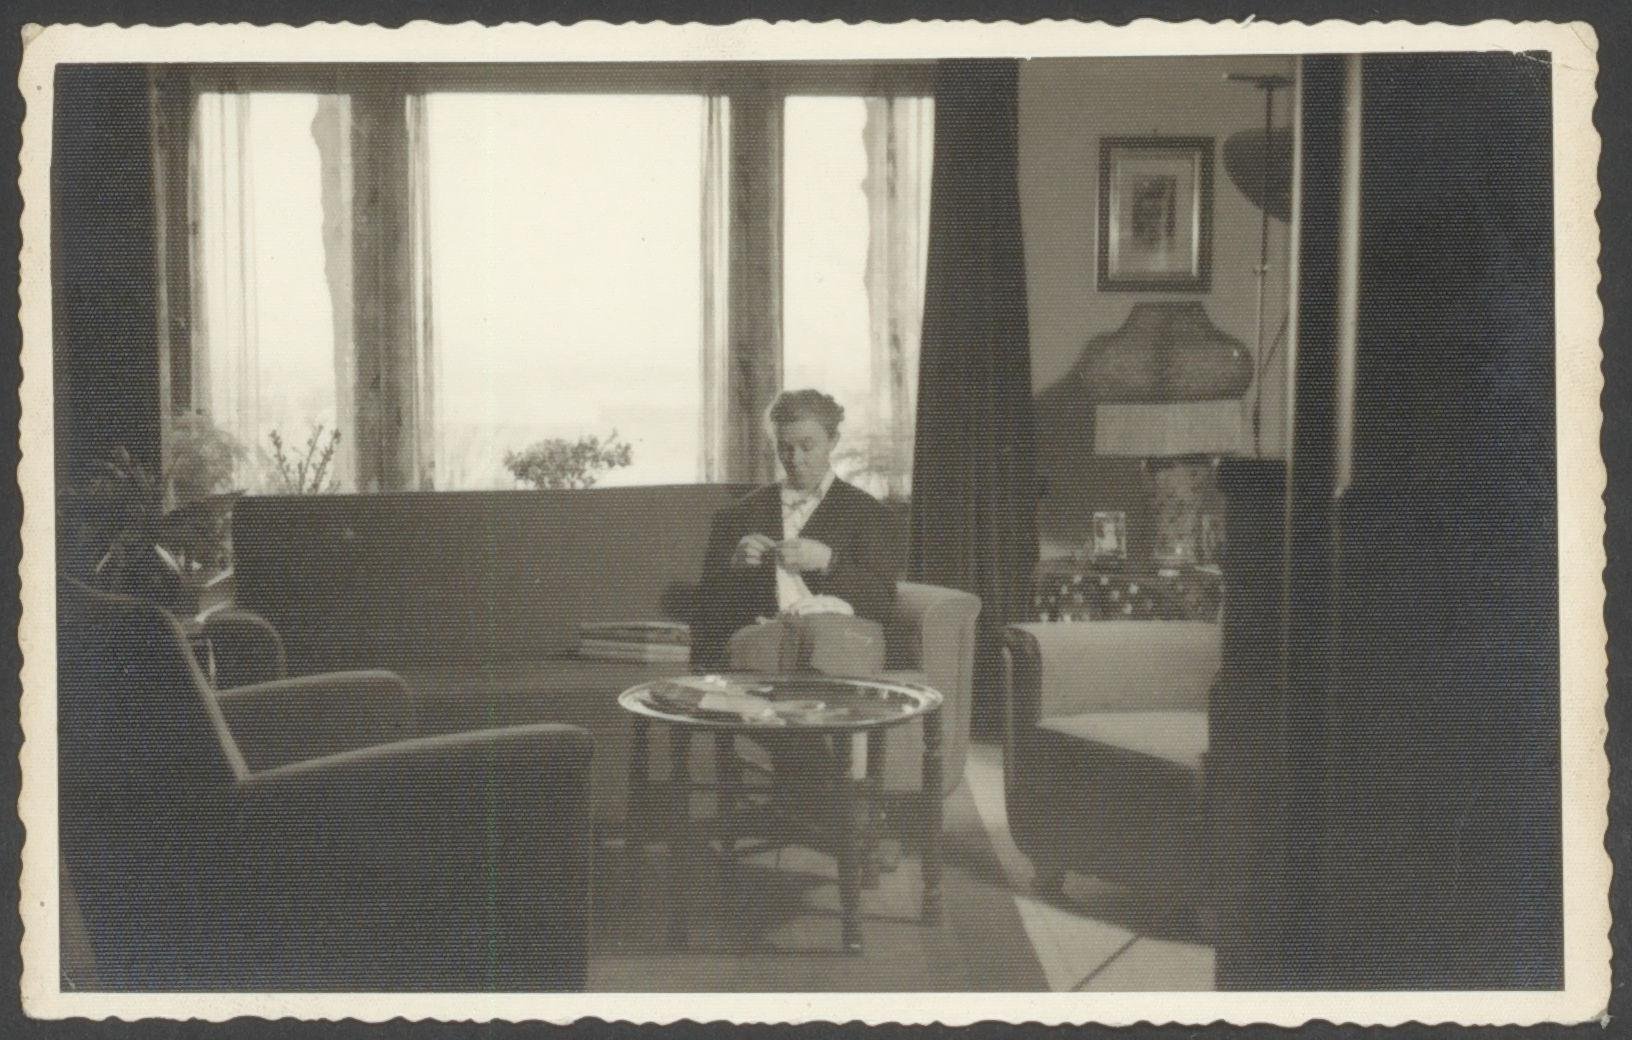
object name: photograph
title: Interieur met breiende vrouw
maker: Anonymous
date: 1955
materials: photographic support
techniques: gelatin silver print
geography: santpoort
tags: surabaya, historical persons, communal rooms, family life at home, knitting, home sewing; repair of clothes